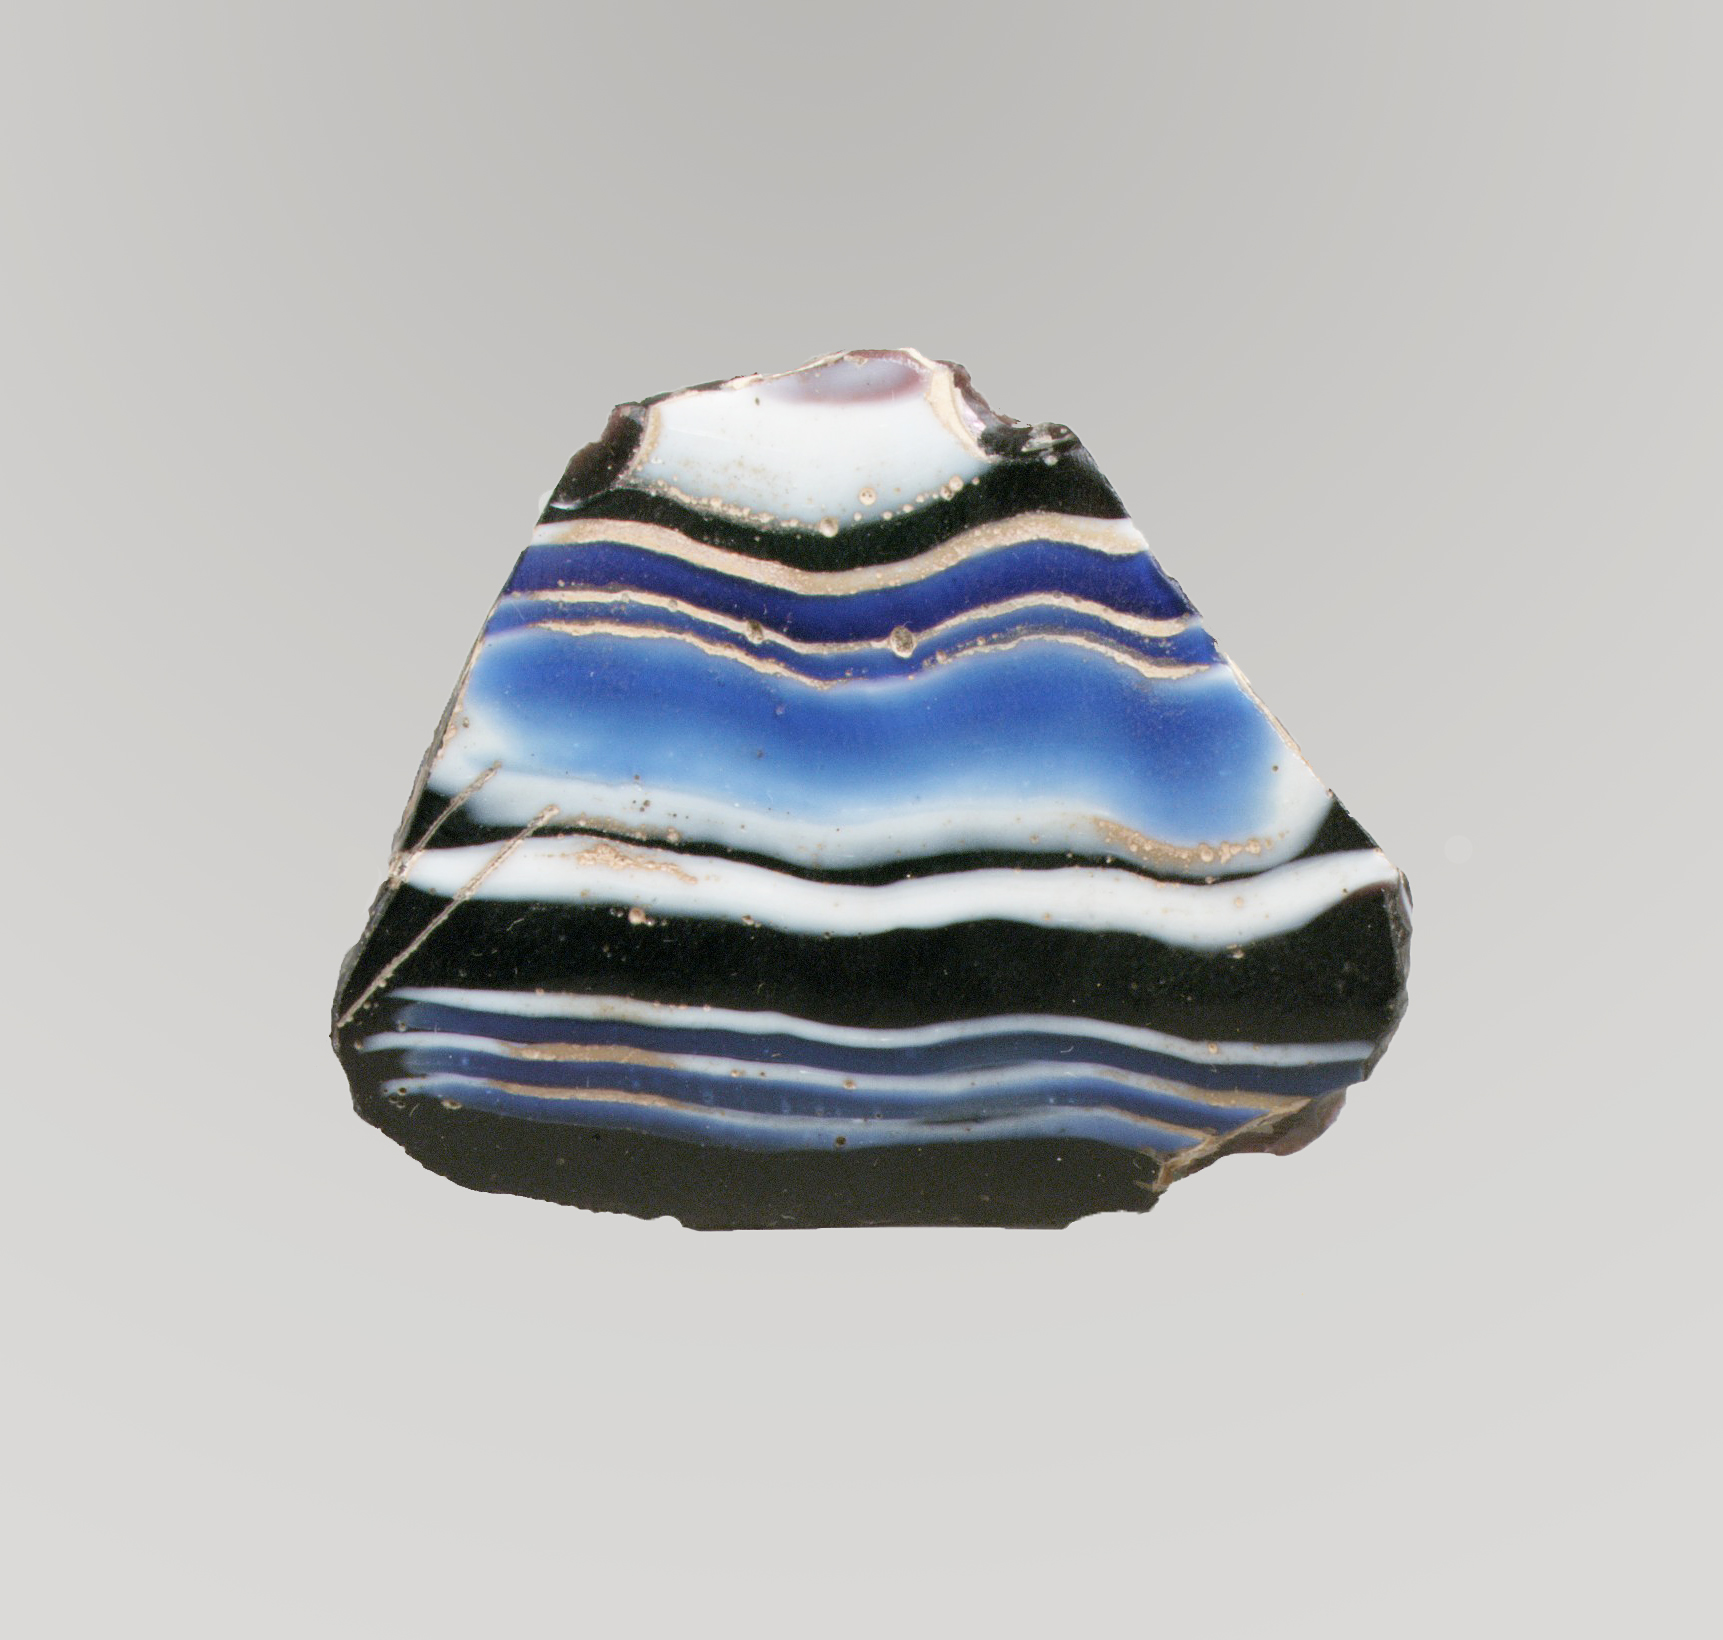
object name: fragment, mosaic bowl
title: Glass mosaic ribbed bowl fragment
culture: roman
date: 34 BCE-33 CE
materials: glass